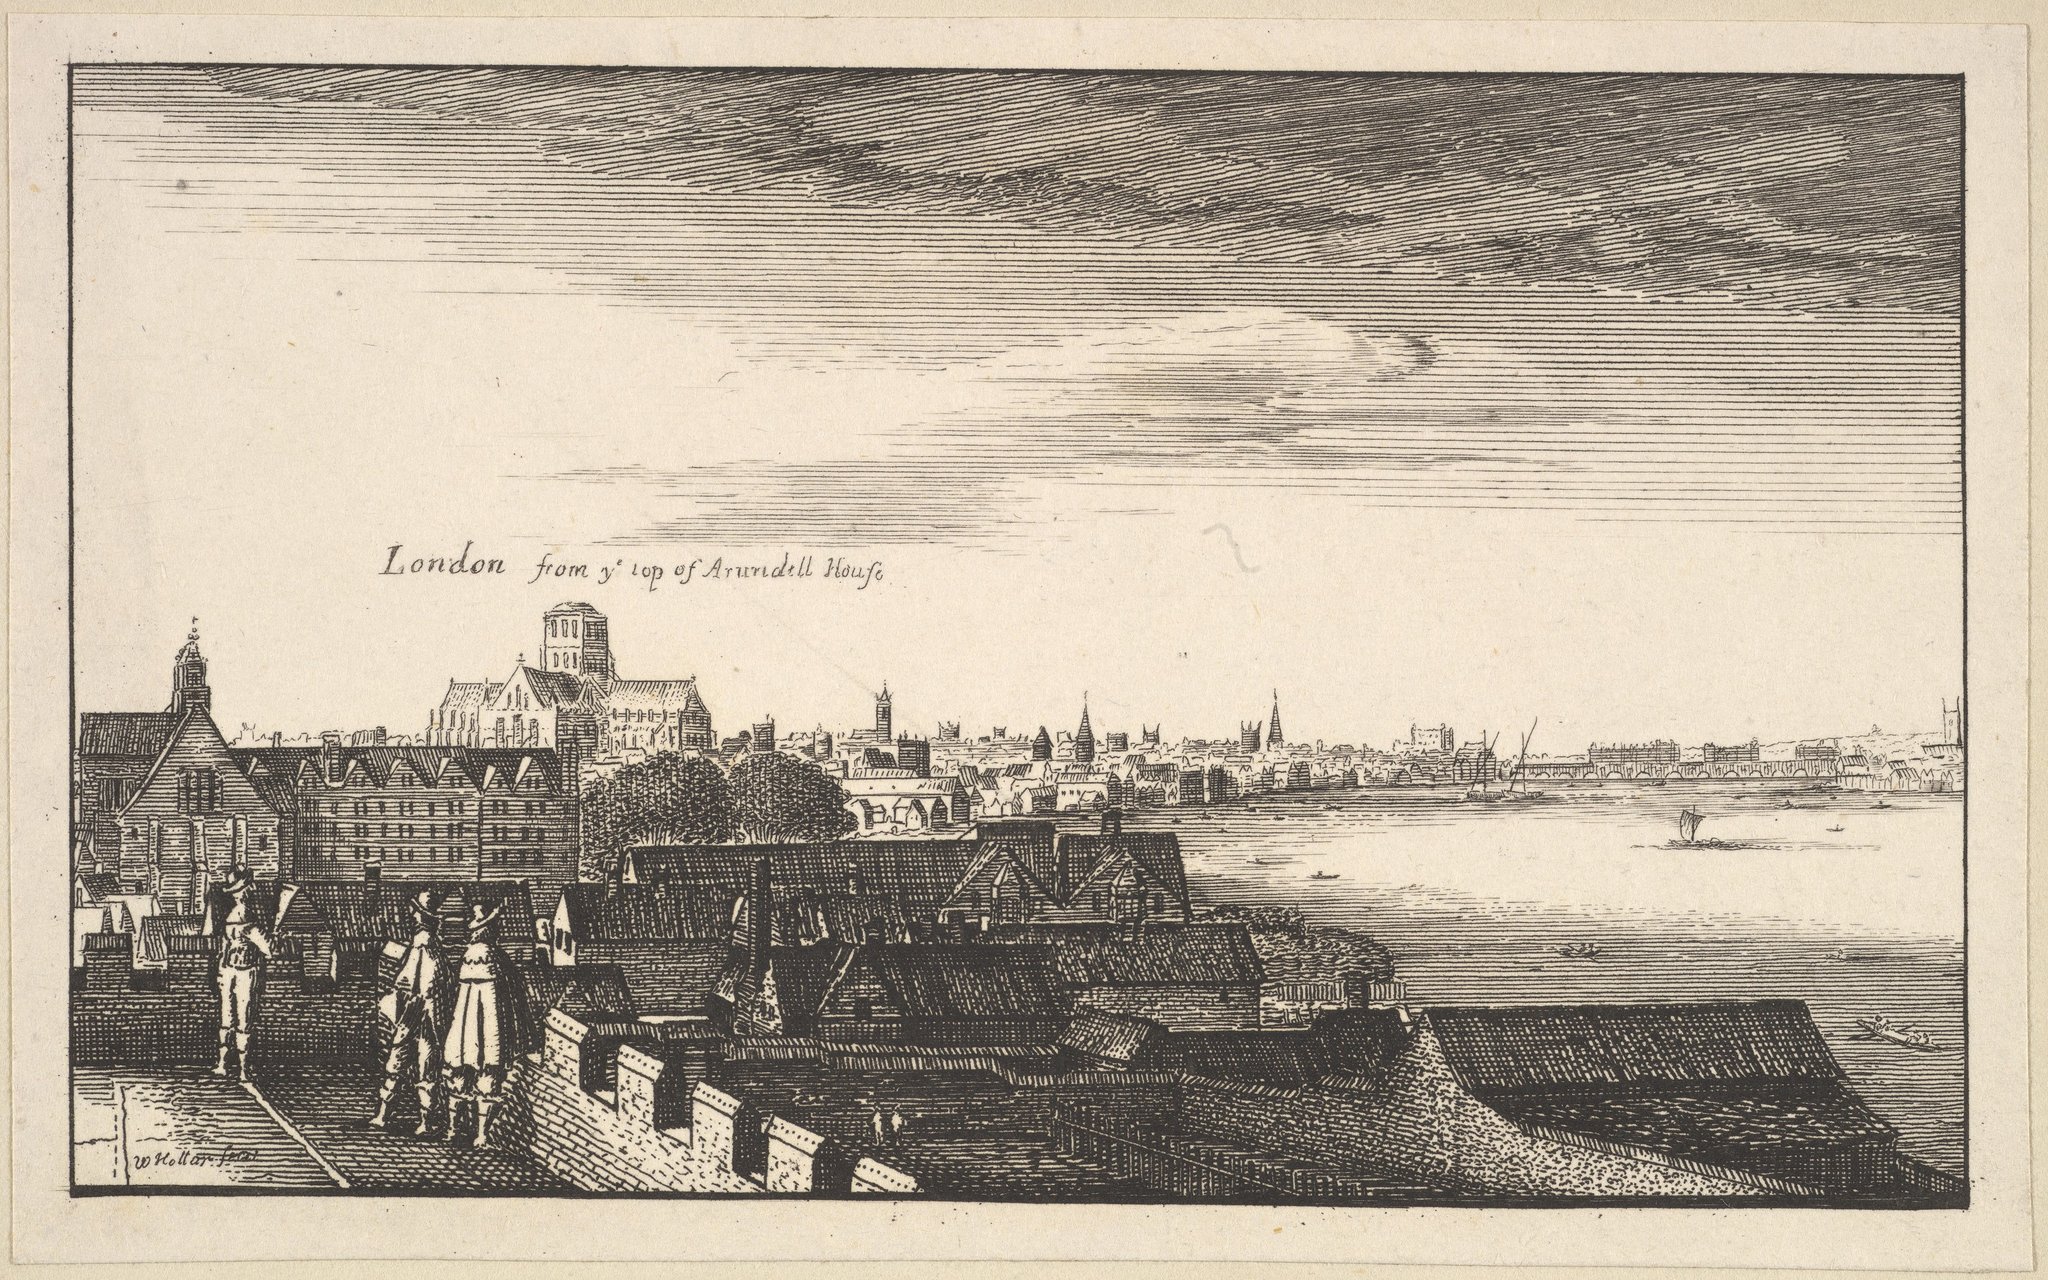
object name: print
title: London from Arundel House (copy)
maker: wenceslaus hollar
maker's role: artist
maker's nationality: bohemian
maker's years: 1607-1677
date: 1601-1700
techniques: etching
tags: buildings,cities,rivers,london